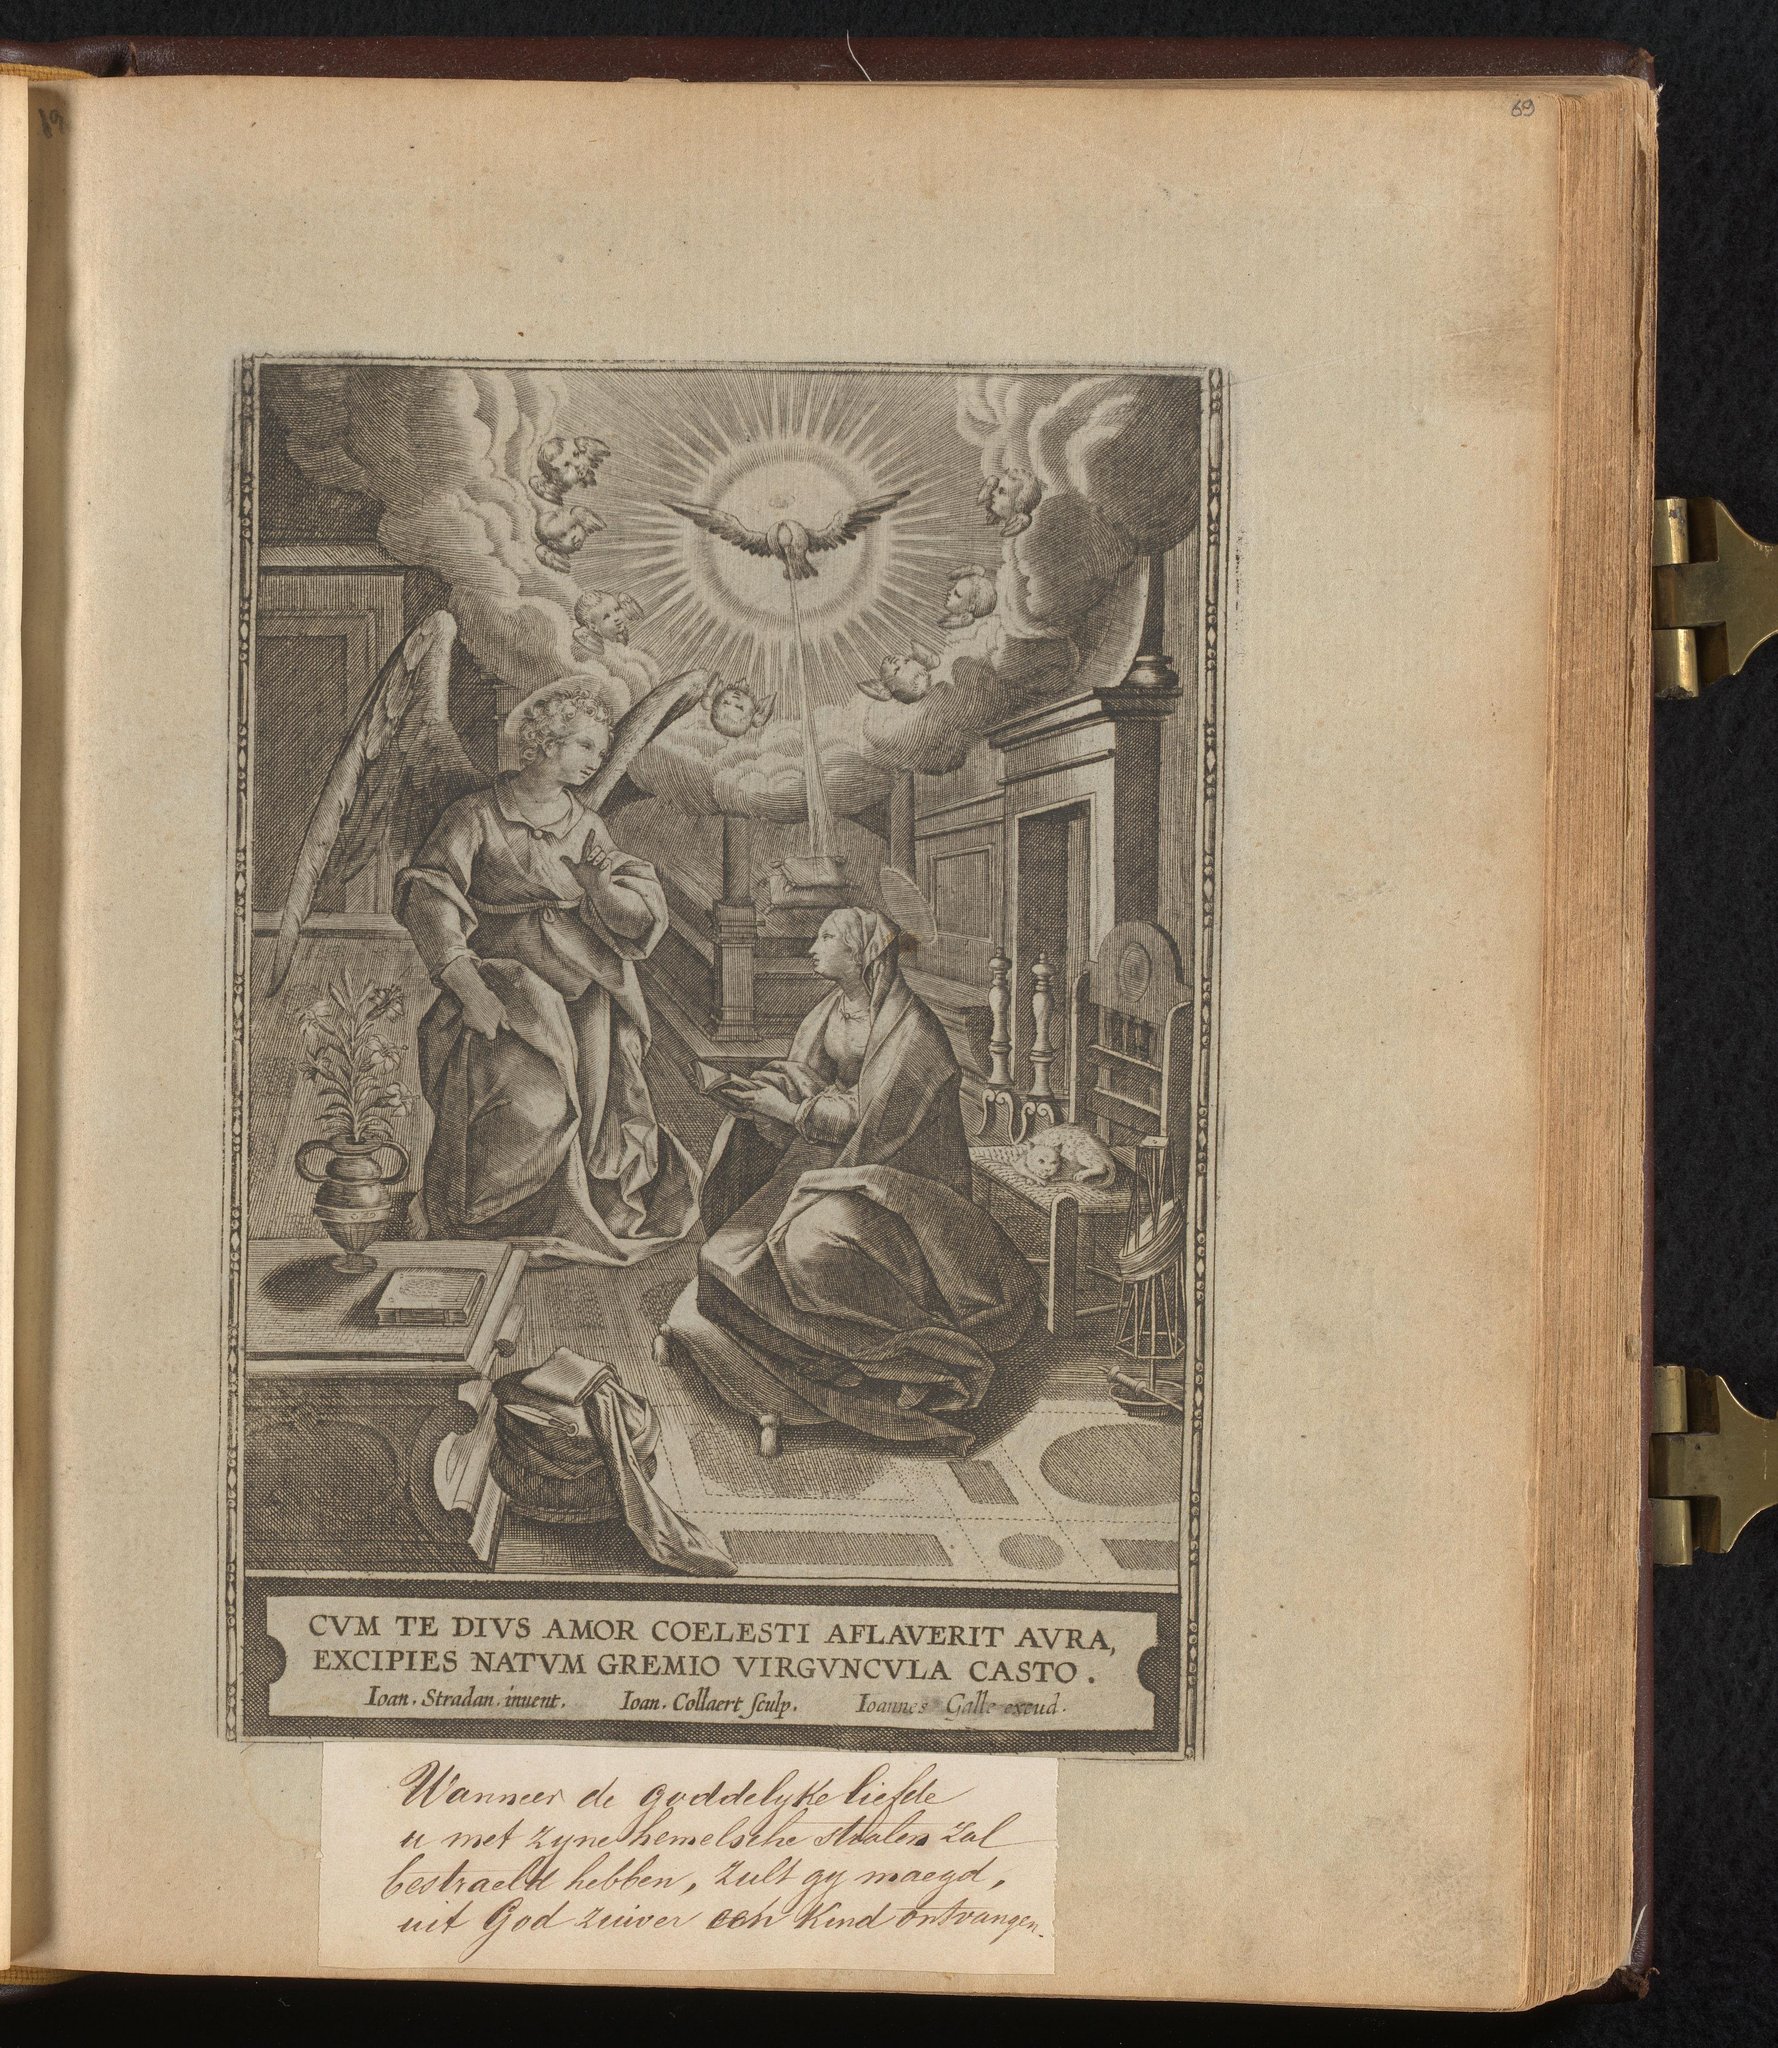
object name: print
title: Annunciatie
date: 1589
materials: paper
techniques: engraving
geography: antwerp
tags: the annunciation: mary sitting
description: Prent maakt deel uit van een prentbijbel.